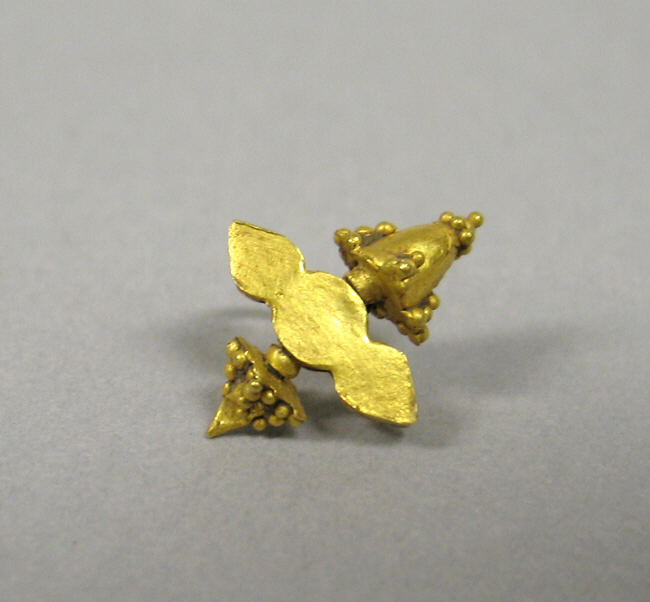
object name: ear clip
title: Pair of Ear Clips with Leaf-Shaped Bezel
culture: indonesian, javanese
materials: gold